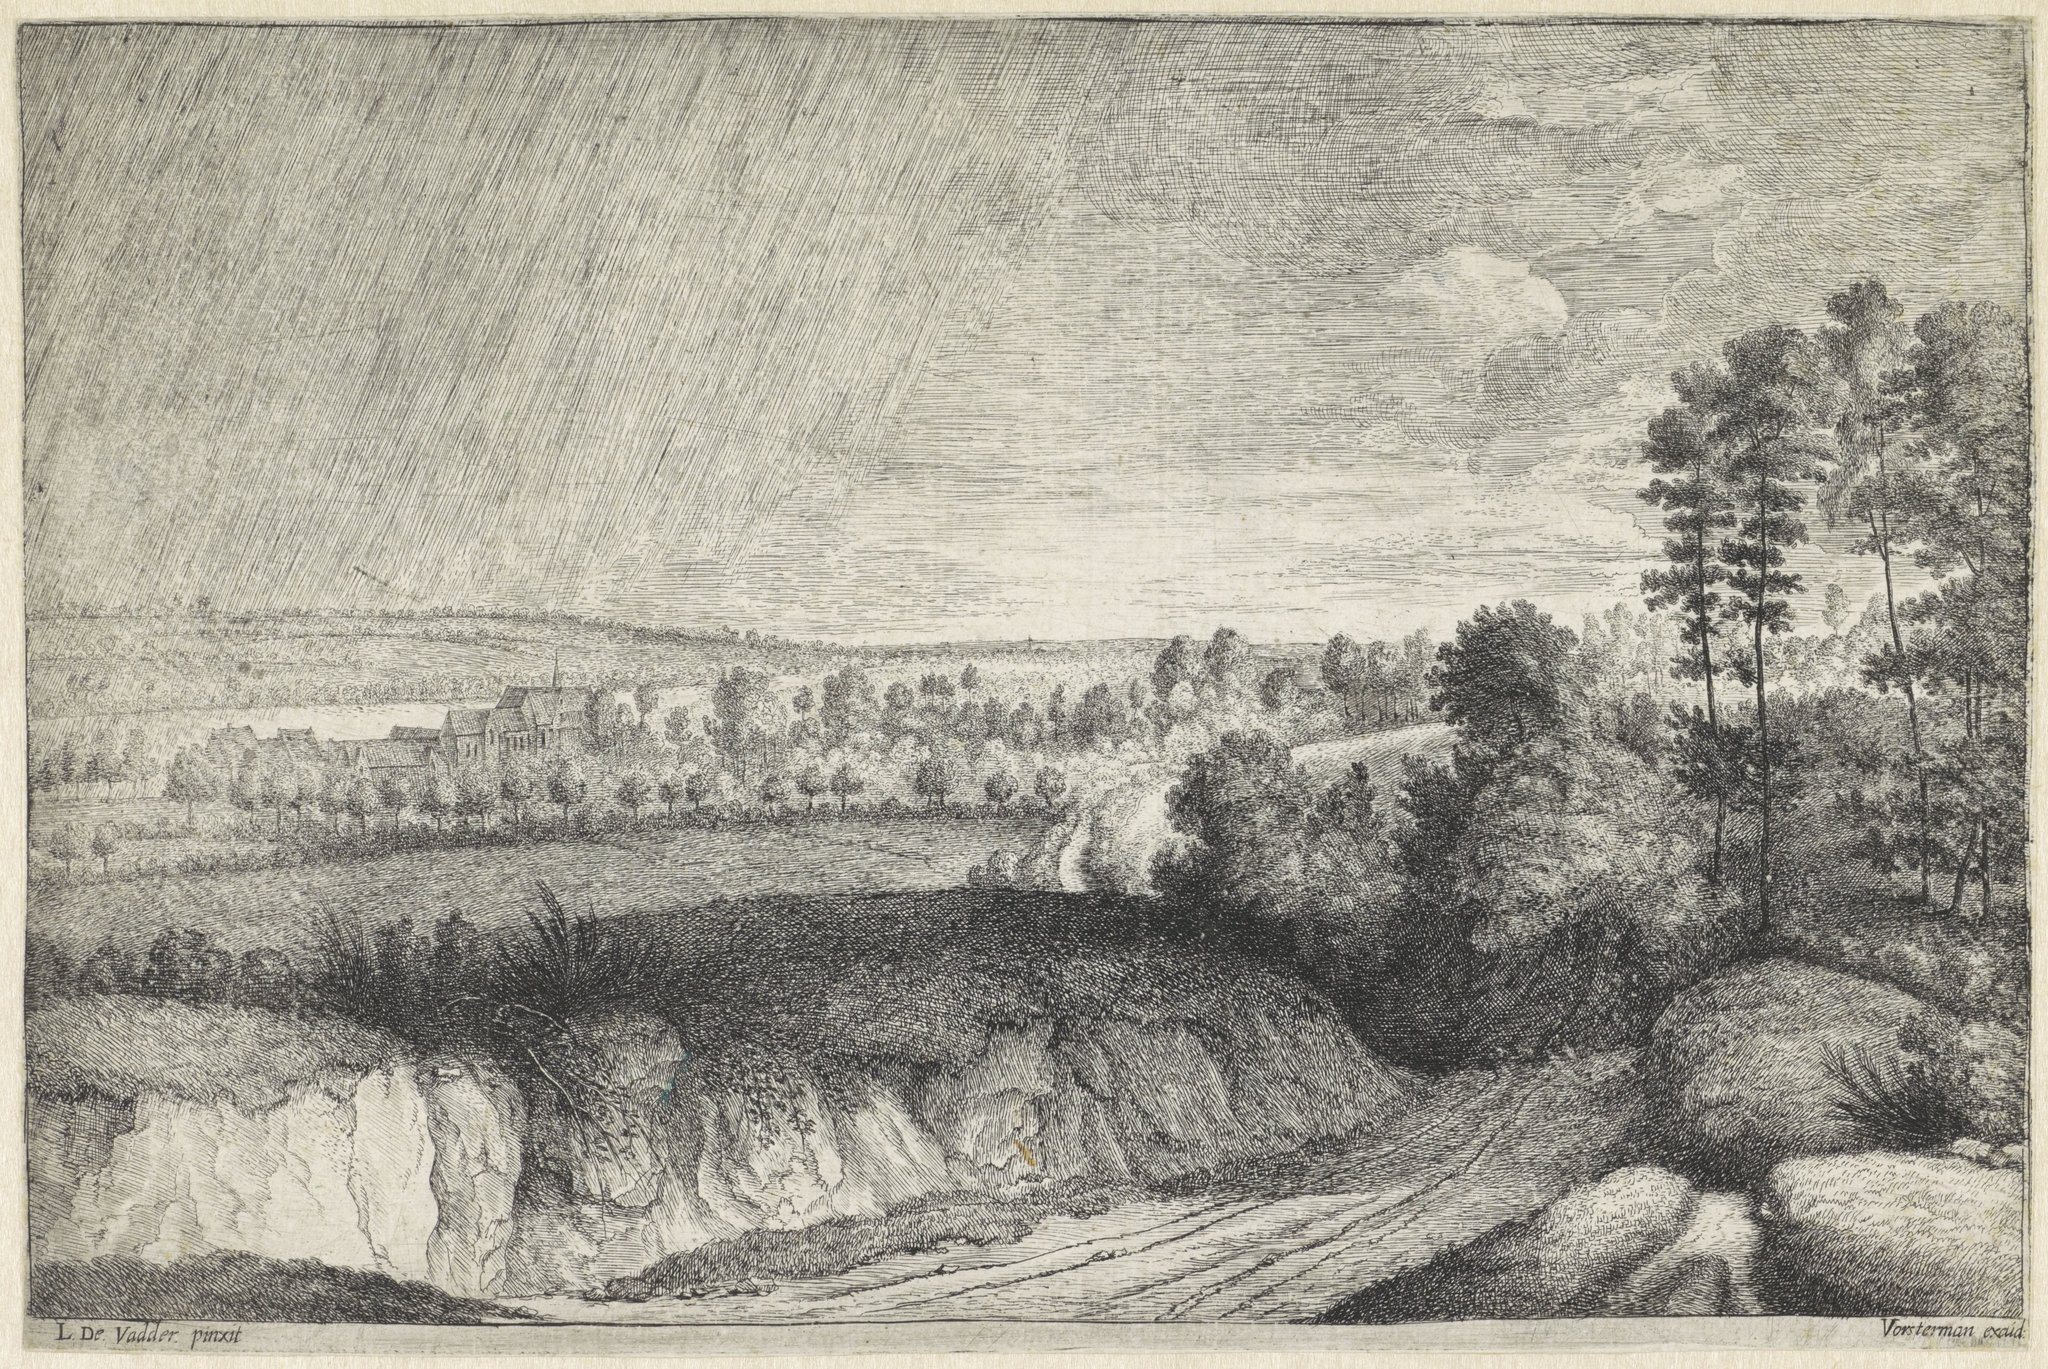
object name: print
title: Landschap in een regenbui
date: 1624-1632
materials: paper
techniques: engraving, etching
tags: meadow, pasture, road, path, rain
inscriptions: collector's mark: Lugt 240, address: ‘Vorsterman excud.’, signature: ‘L. de Vadder pinxit’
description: Een landschap tijdens een regenbui. Op de voorgrond een pad met een karrenspoor. Rechts een bomengroep. Middenachter een dorp met een kerk tussen de velden.